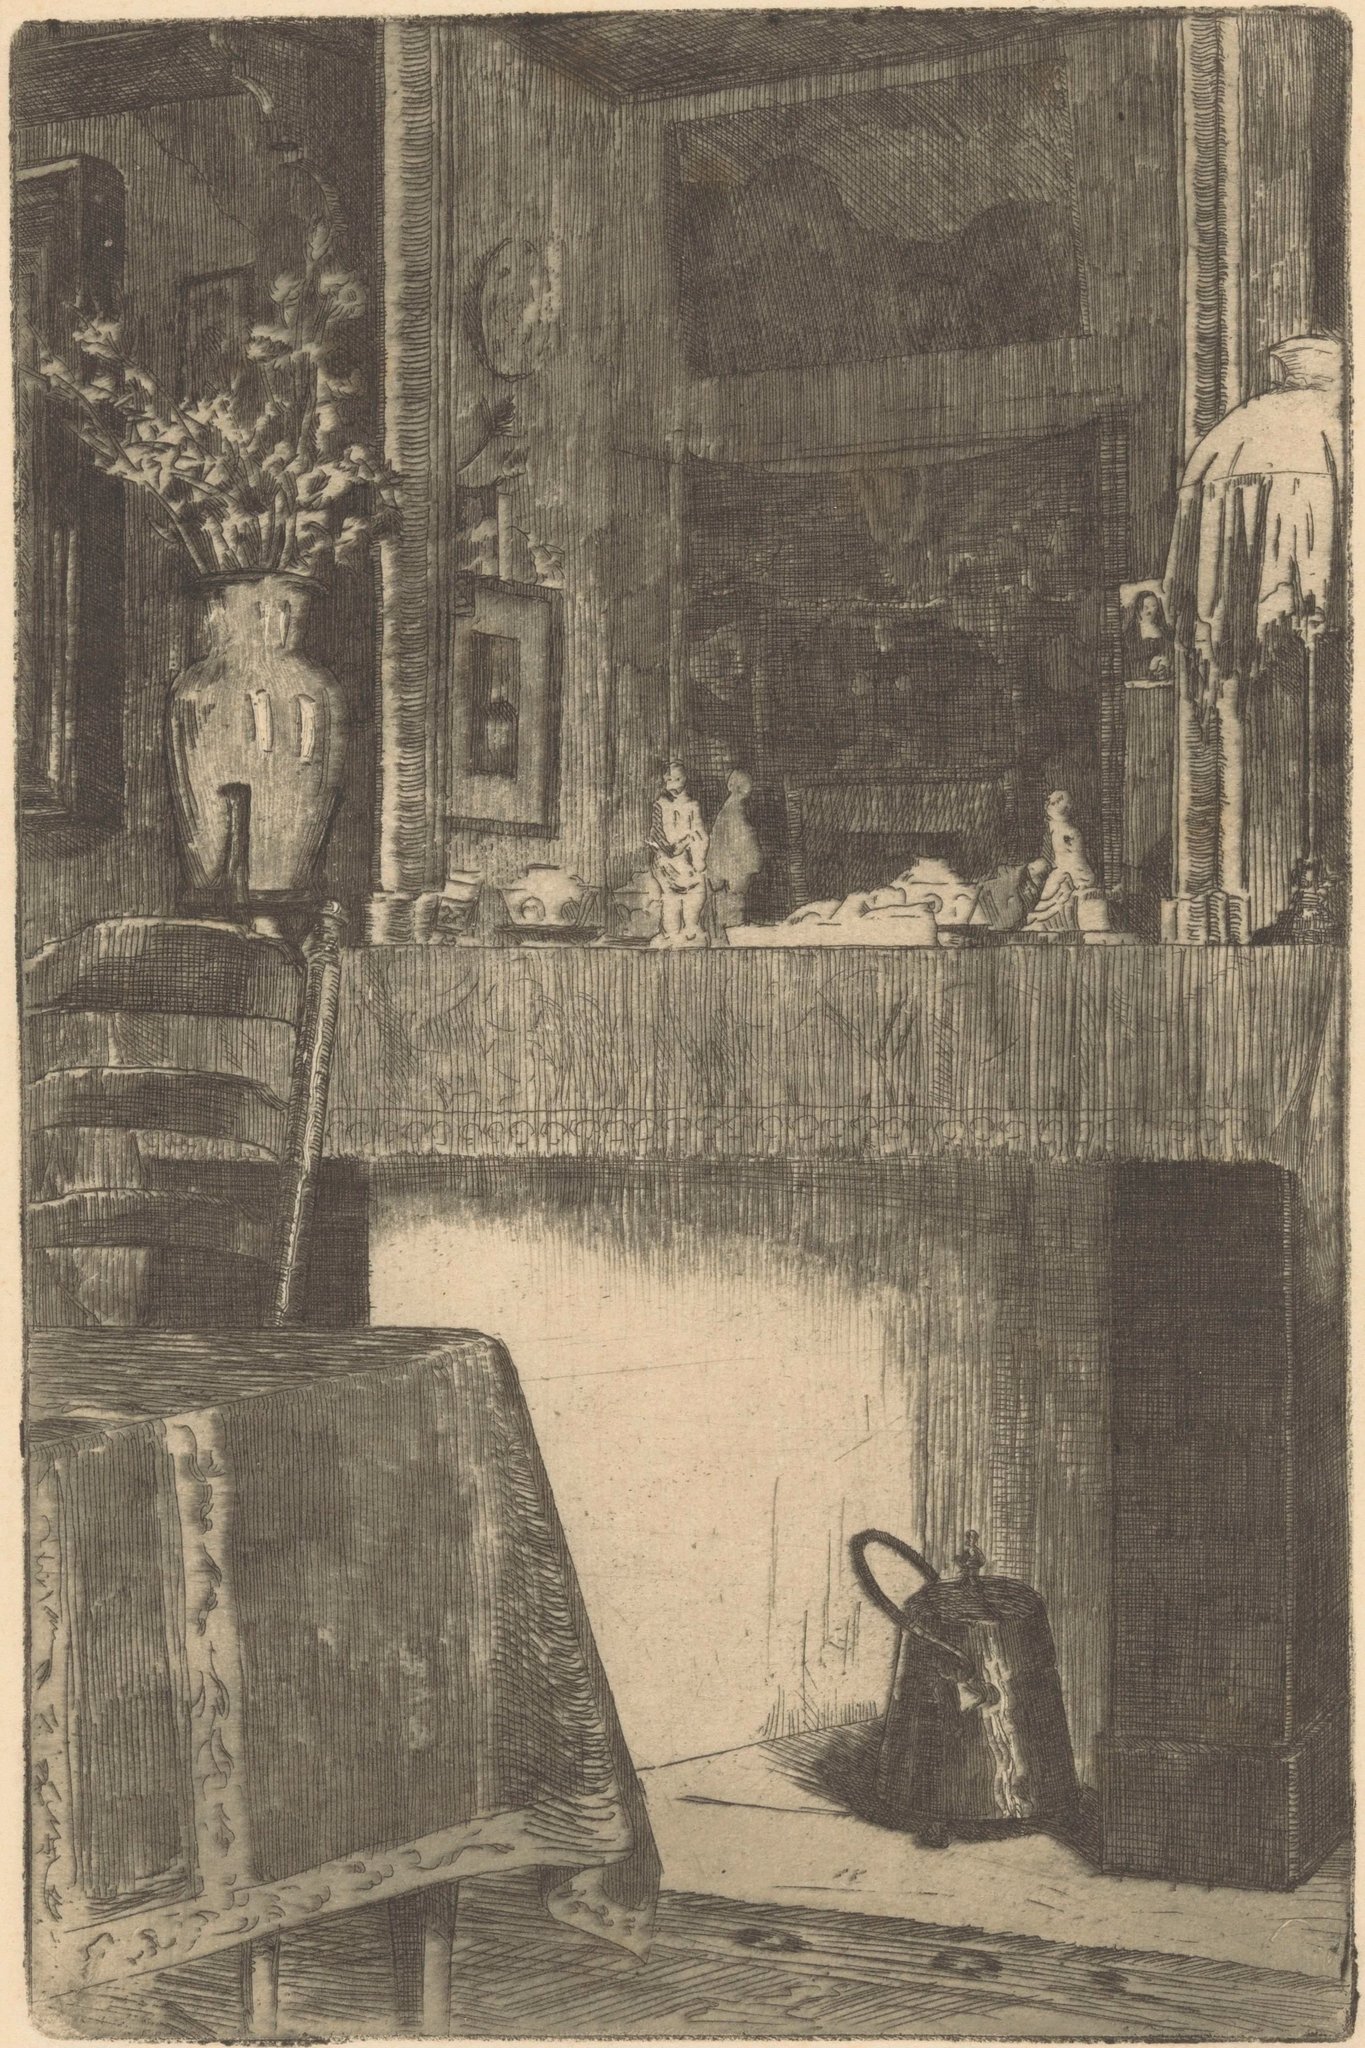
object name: print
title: Atelierhoekje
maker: willem adrianus grondhout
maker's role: draughtsman, painter, print maker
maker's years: 1878-1934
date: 1888-1934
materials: paper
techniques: etching, intaglio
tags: mirror, chimney-piece, mantelpiece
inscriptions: collector's mark: Lugt 2228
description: Op de schoorsteenmantel staan verschillende soorten objecten, waaronder een bloemenvaas, een lamp en sculpturen. Voor de schoorsteenmantel staat een tafel met tafelkleed.